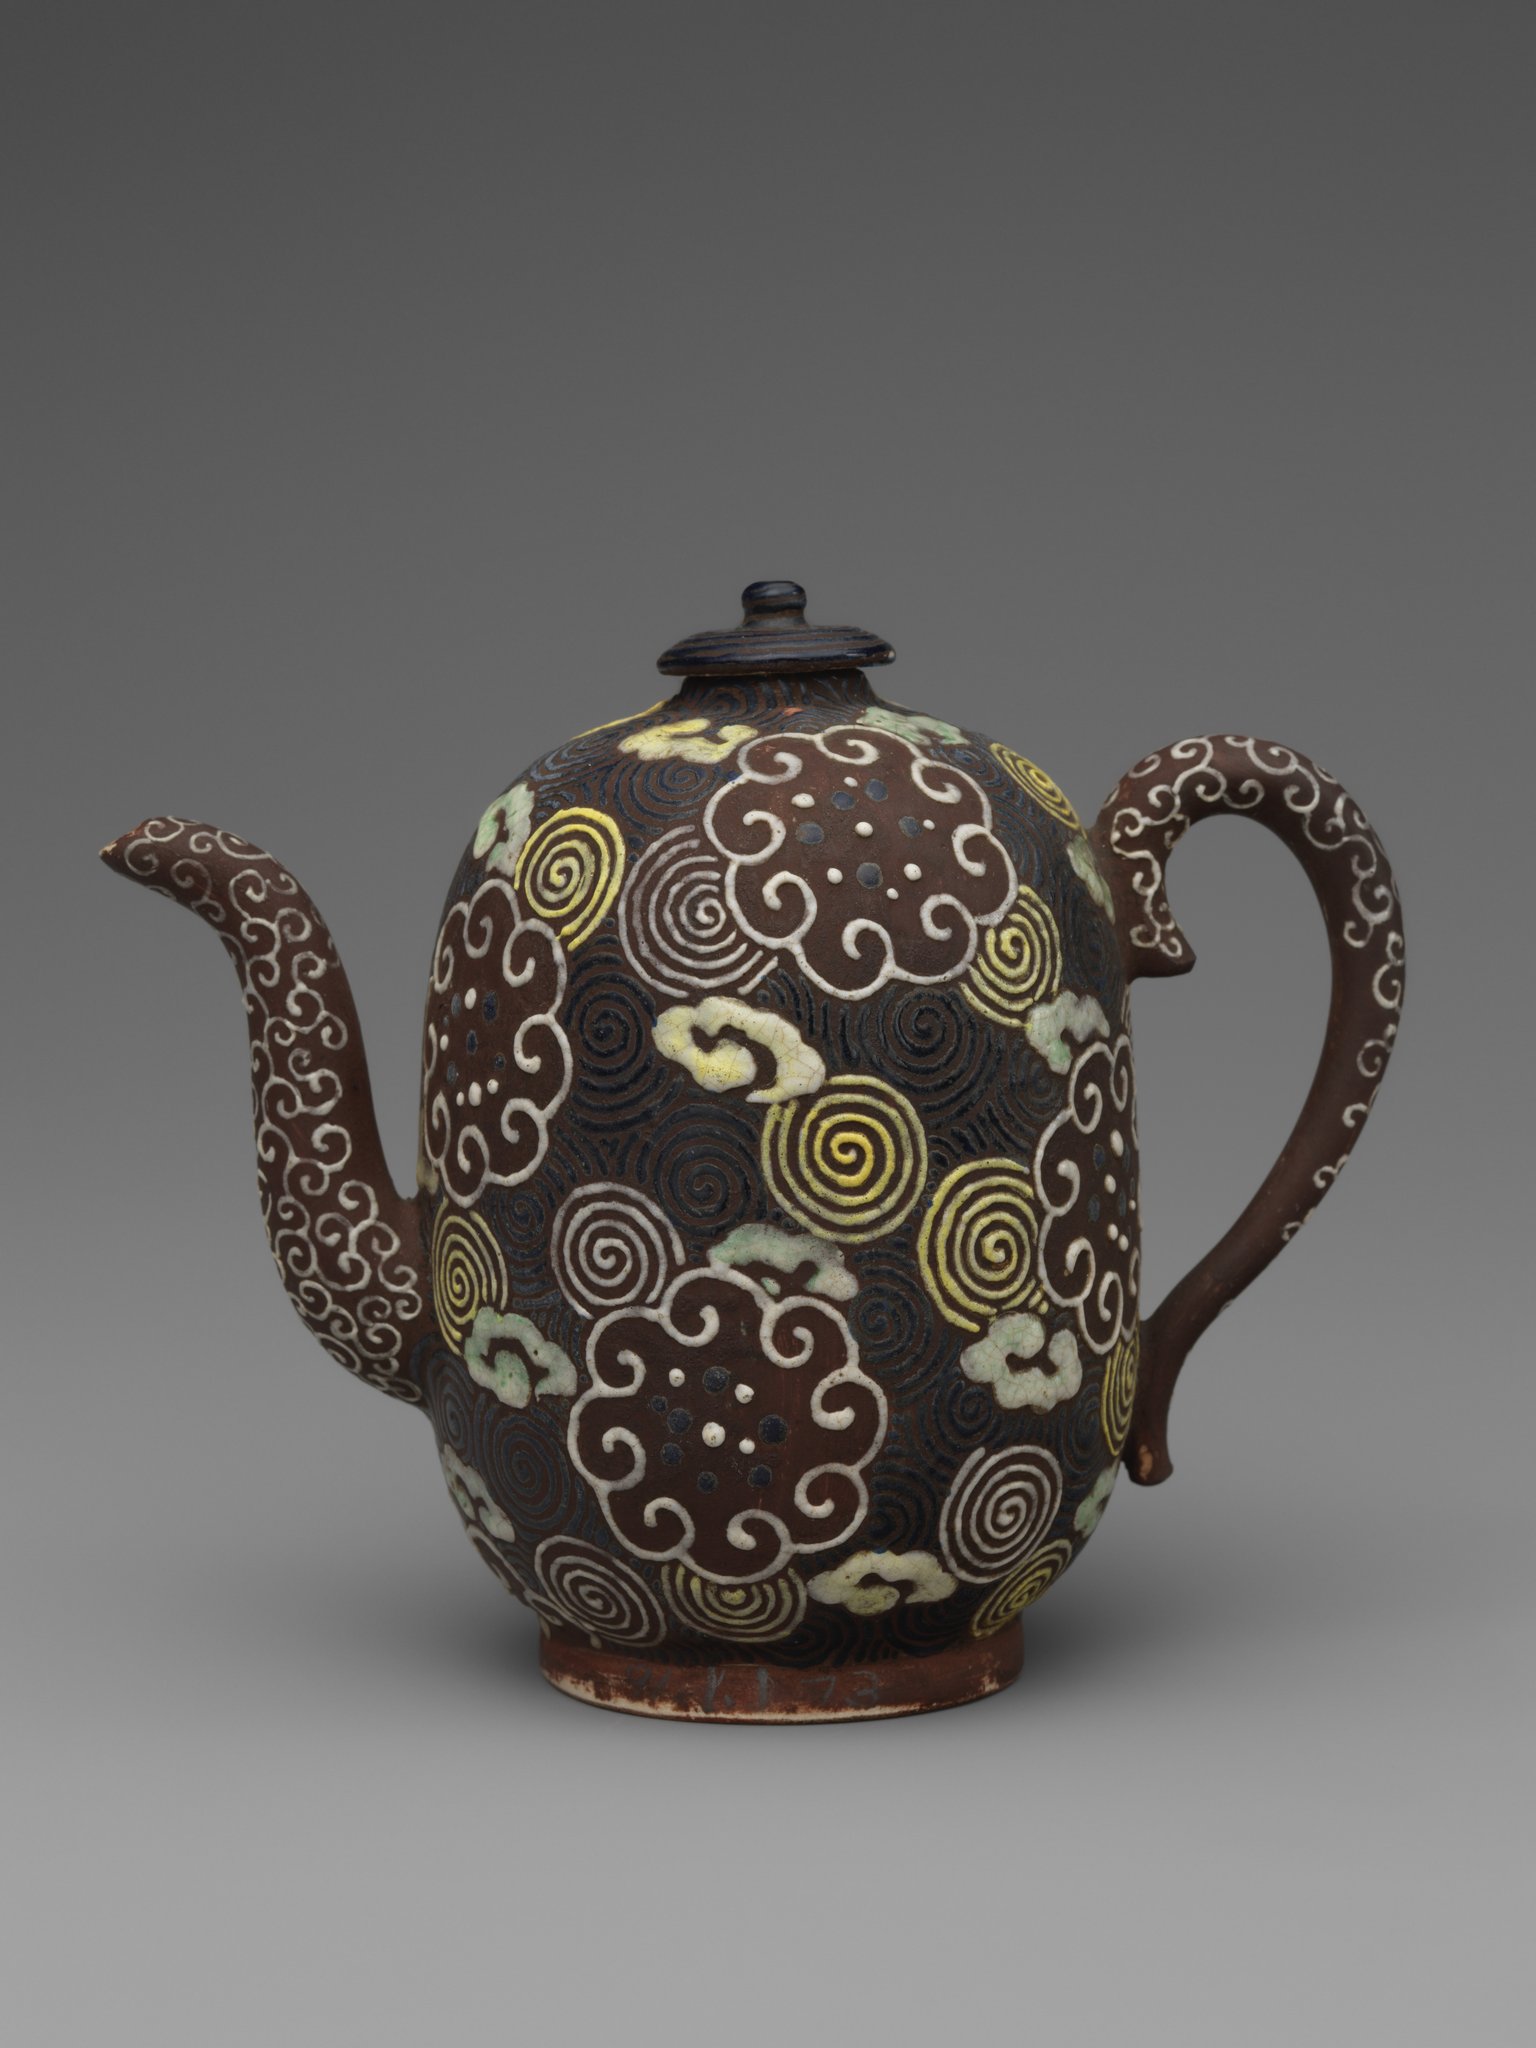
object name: waterpot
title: Waterpot (Suichū)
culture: japanese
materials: stoneware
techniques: polychrome